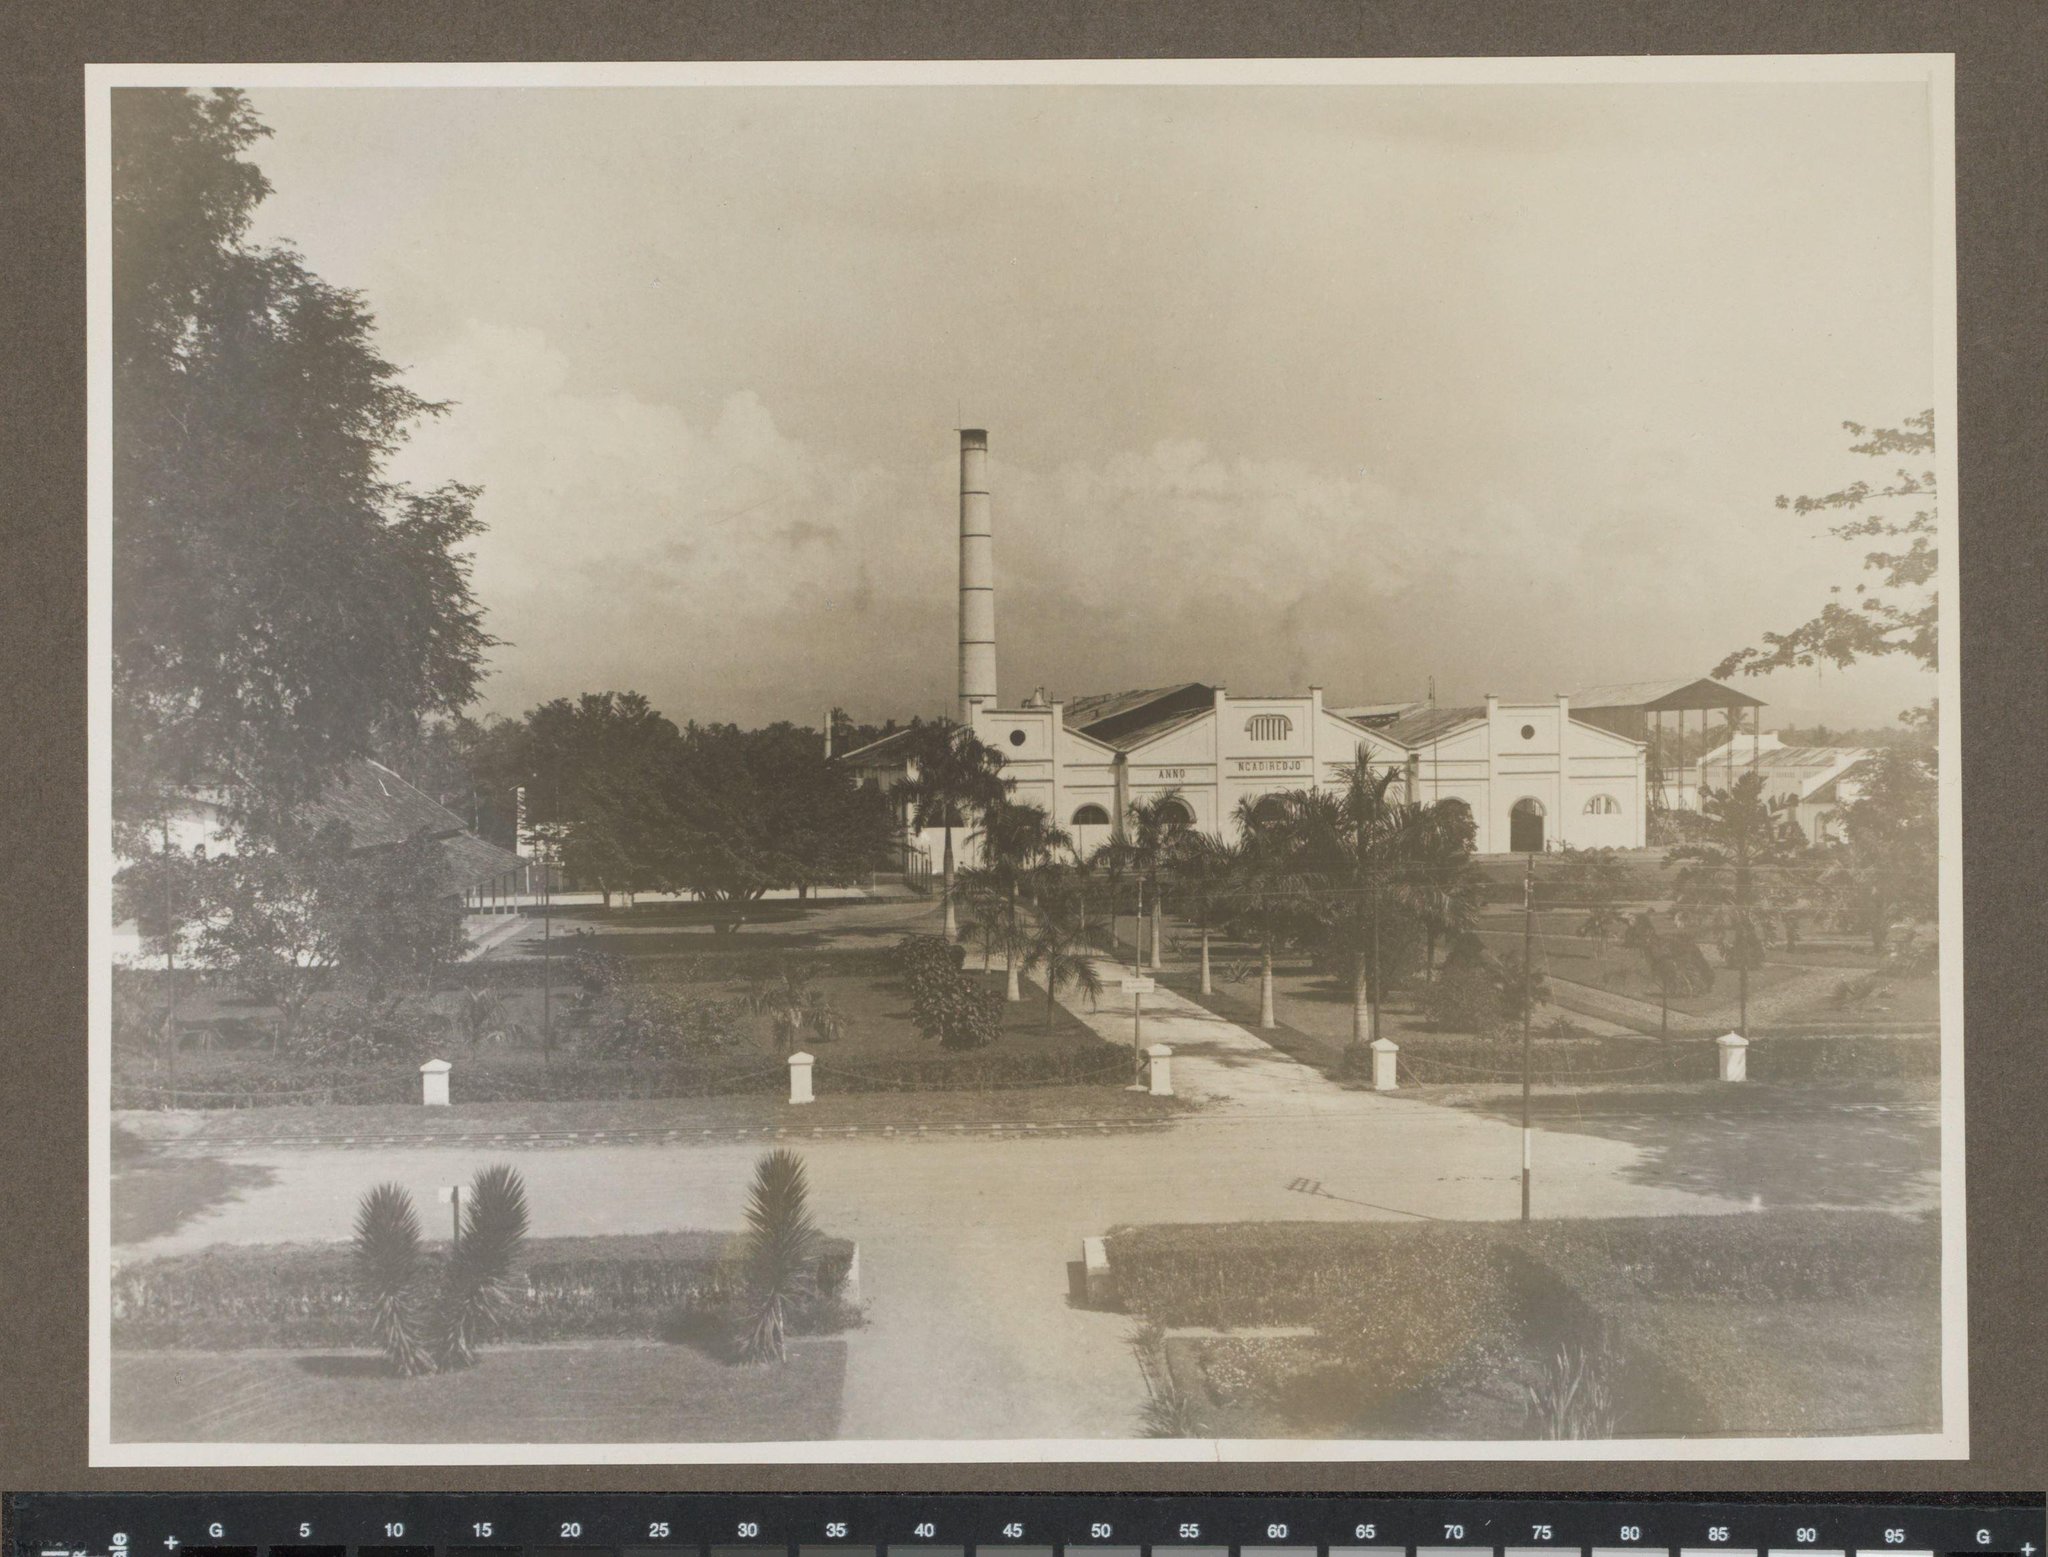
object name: photograph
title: Ngadiredjo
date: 1904-1931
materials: photographic support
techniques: gelatin silver print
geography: surabaya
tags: colonial system, trade-company, (non-fruit) products of plants or trees: sugarcane, sea and coastal fishery, surabaya, java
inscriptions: inscription: ‘Ngadiredjo.’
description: Gezicht op de suikeronderneming te Ngadiredjo (Ngadirejo). Foto in het het fotoalbum aangeboden aan A. van der Eyk namens de chefs en het personeel van de Handelsvereniging Amsterdam (HVA) te Soerabaja bij zijn vertrek van Java in april 1931.